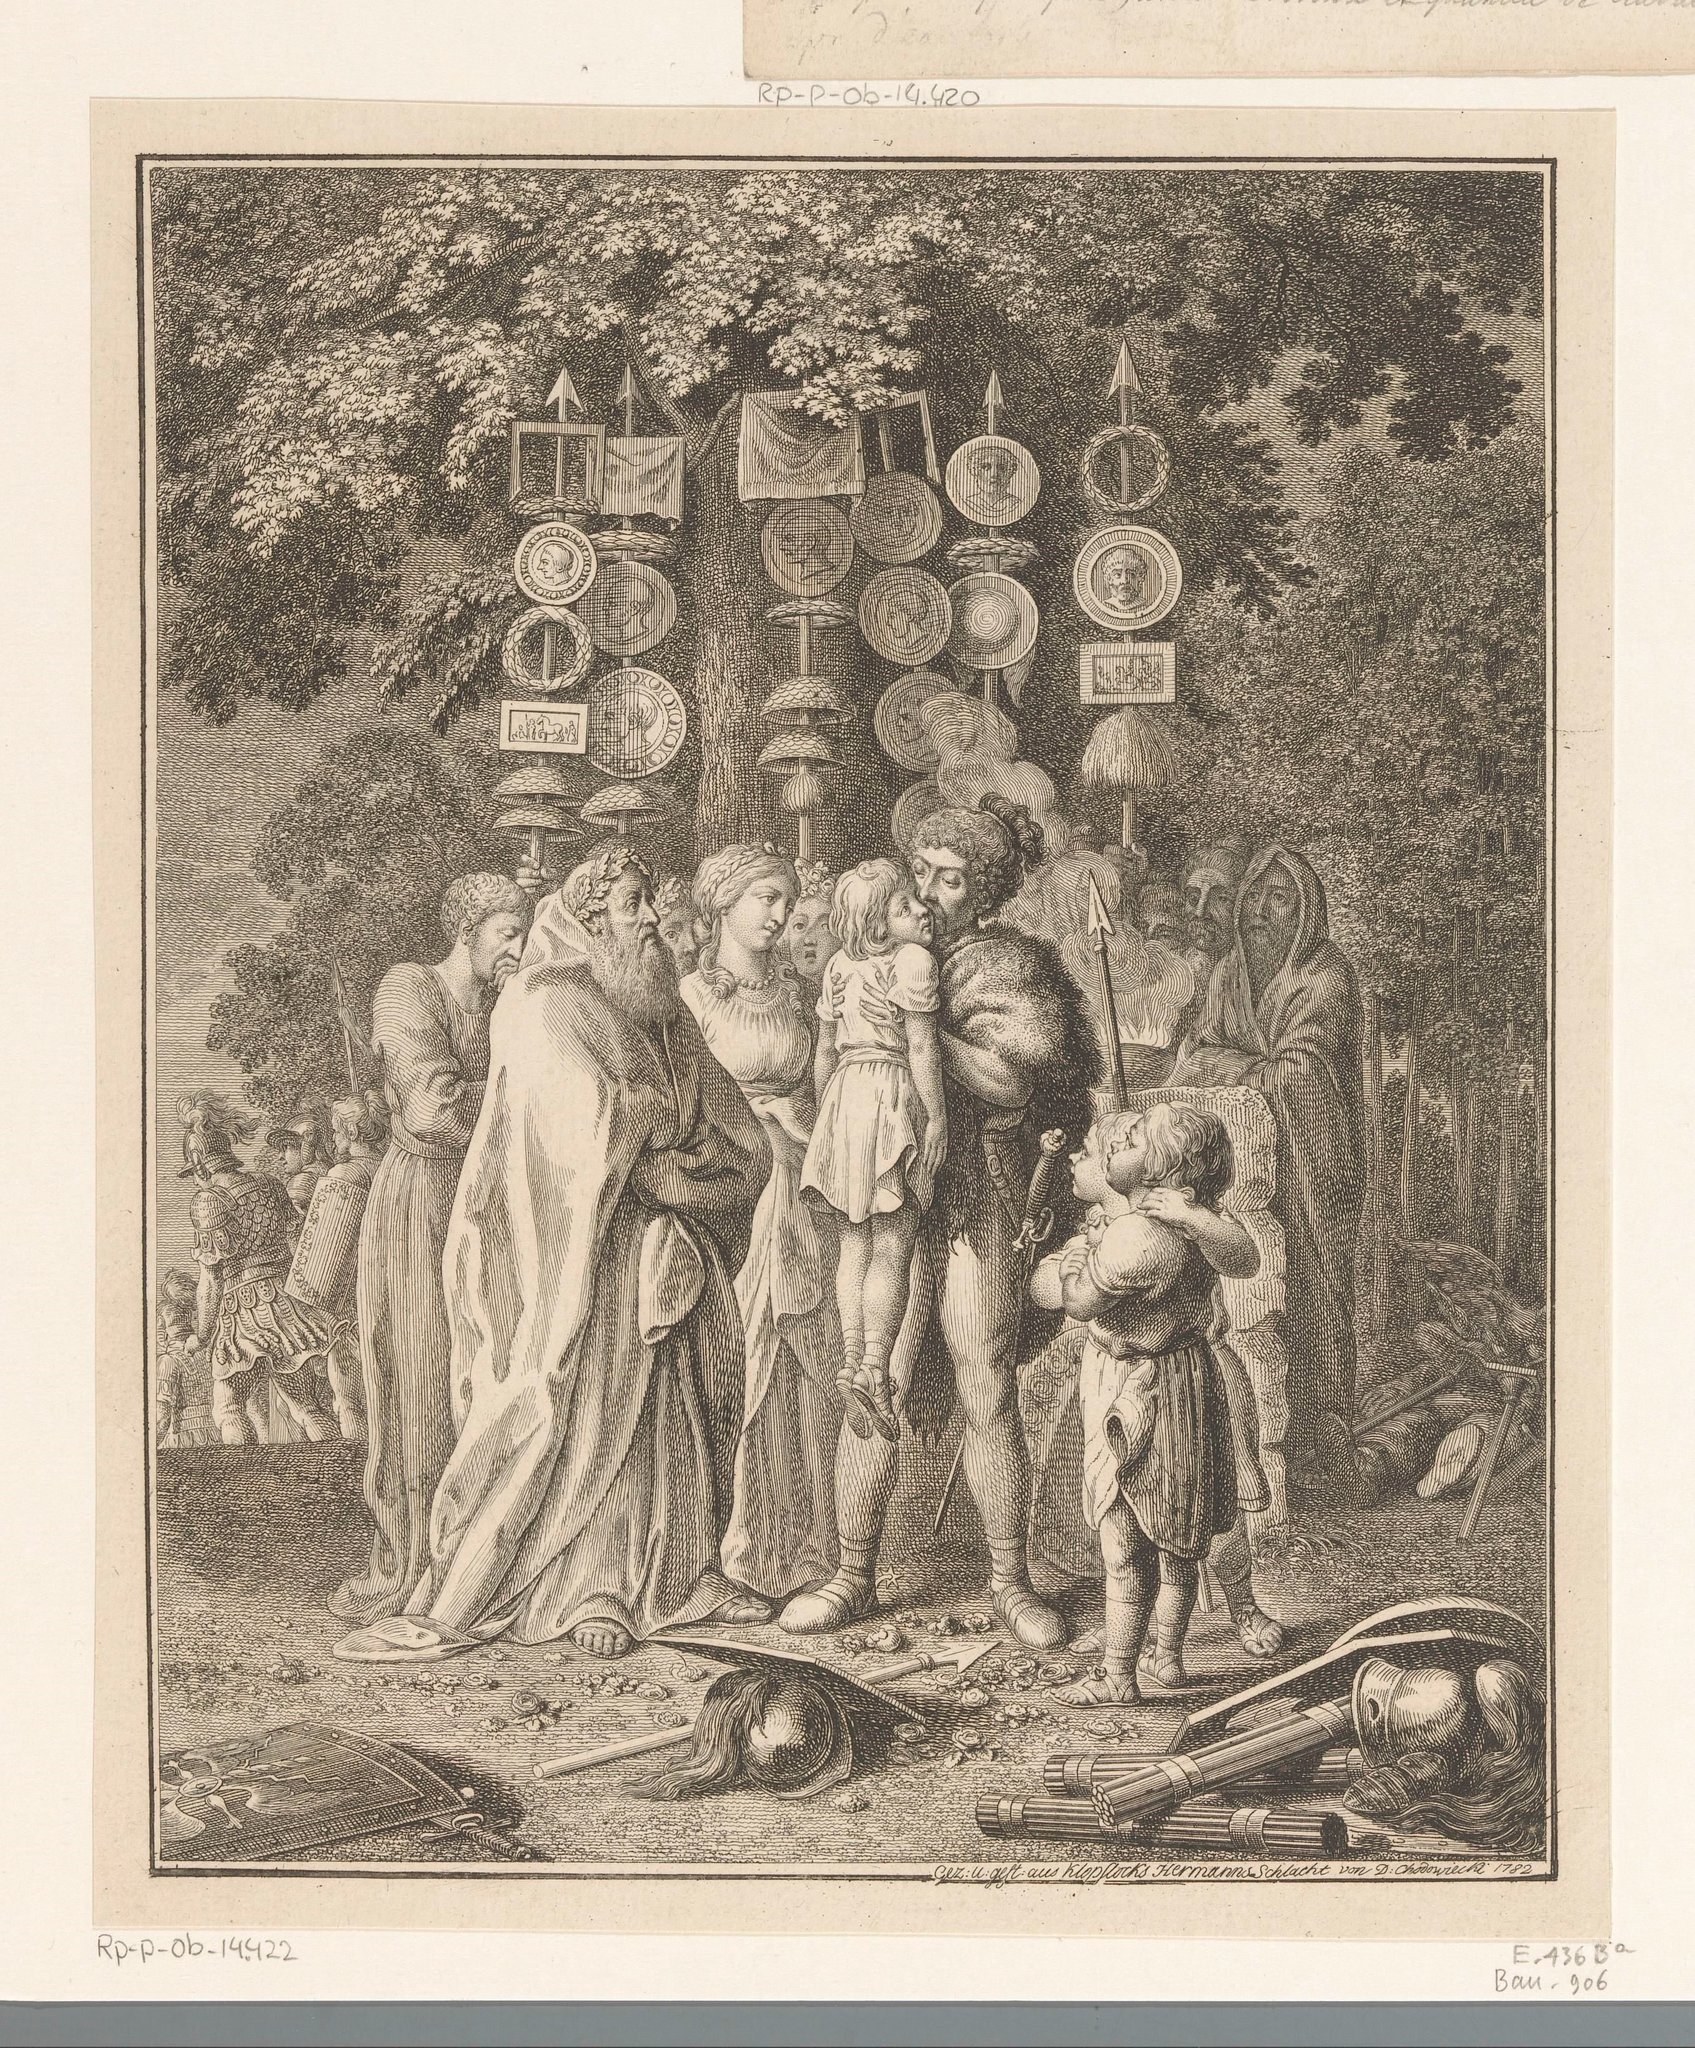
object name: print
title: Germaanse veldheer Arminius kust voor de heilige eik een verwonde schildknaap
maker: daniel nikolaus chodowiecki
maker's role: draughtsman, print maker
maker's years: 1726-1801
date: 1782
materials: paper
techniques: etching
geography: berlin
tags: helmet, protective weapons: shield, germanic and scandinavian religions, religious functionaries ~ germanic and scandiavian religions, trees: oak, (military) flags and standards, victory ~ armed conflict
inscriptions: collector's mark: Lugt 2228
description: Prent gebruikt voor: Klein, Anton. Leben und Bildnisse der Grossen Deutschen, von verschiedenen Verfassern und Künstlern (...). 3 dln. Mannheim: s.n., 1785, dl. 1.